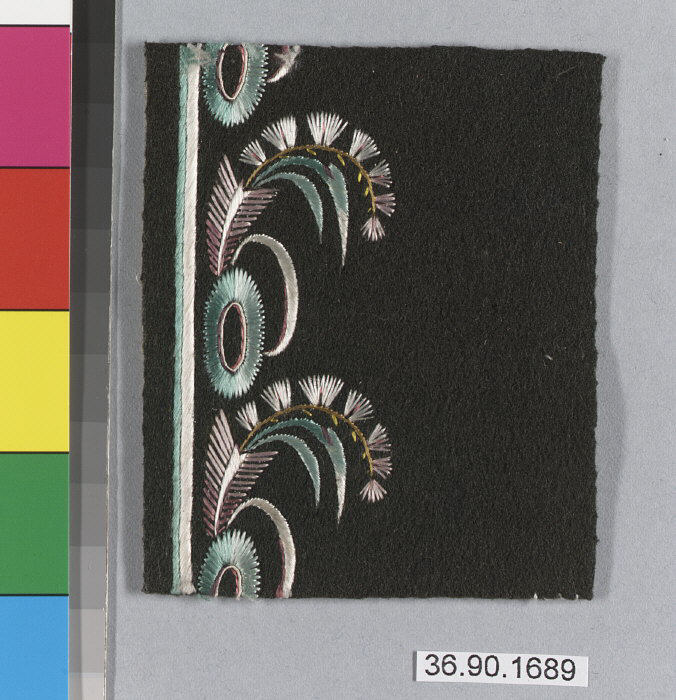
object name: sample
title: Embroidery sample for a man’s suit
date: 1785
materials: silk, wool